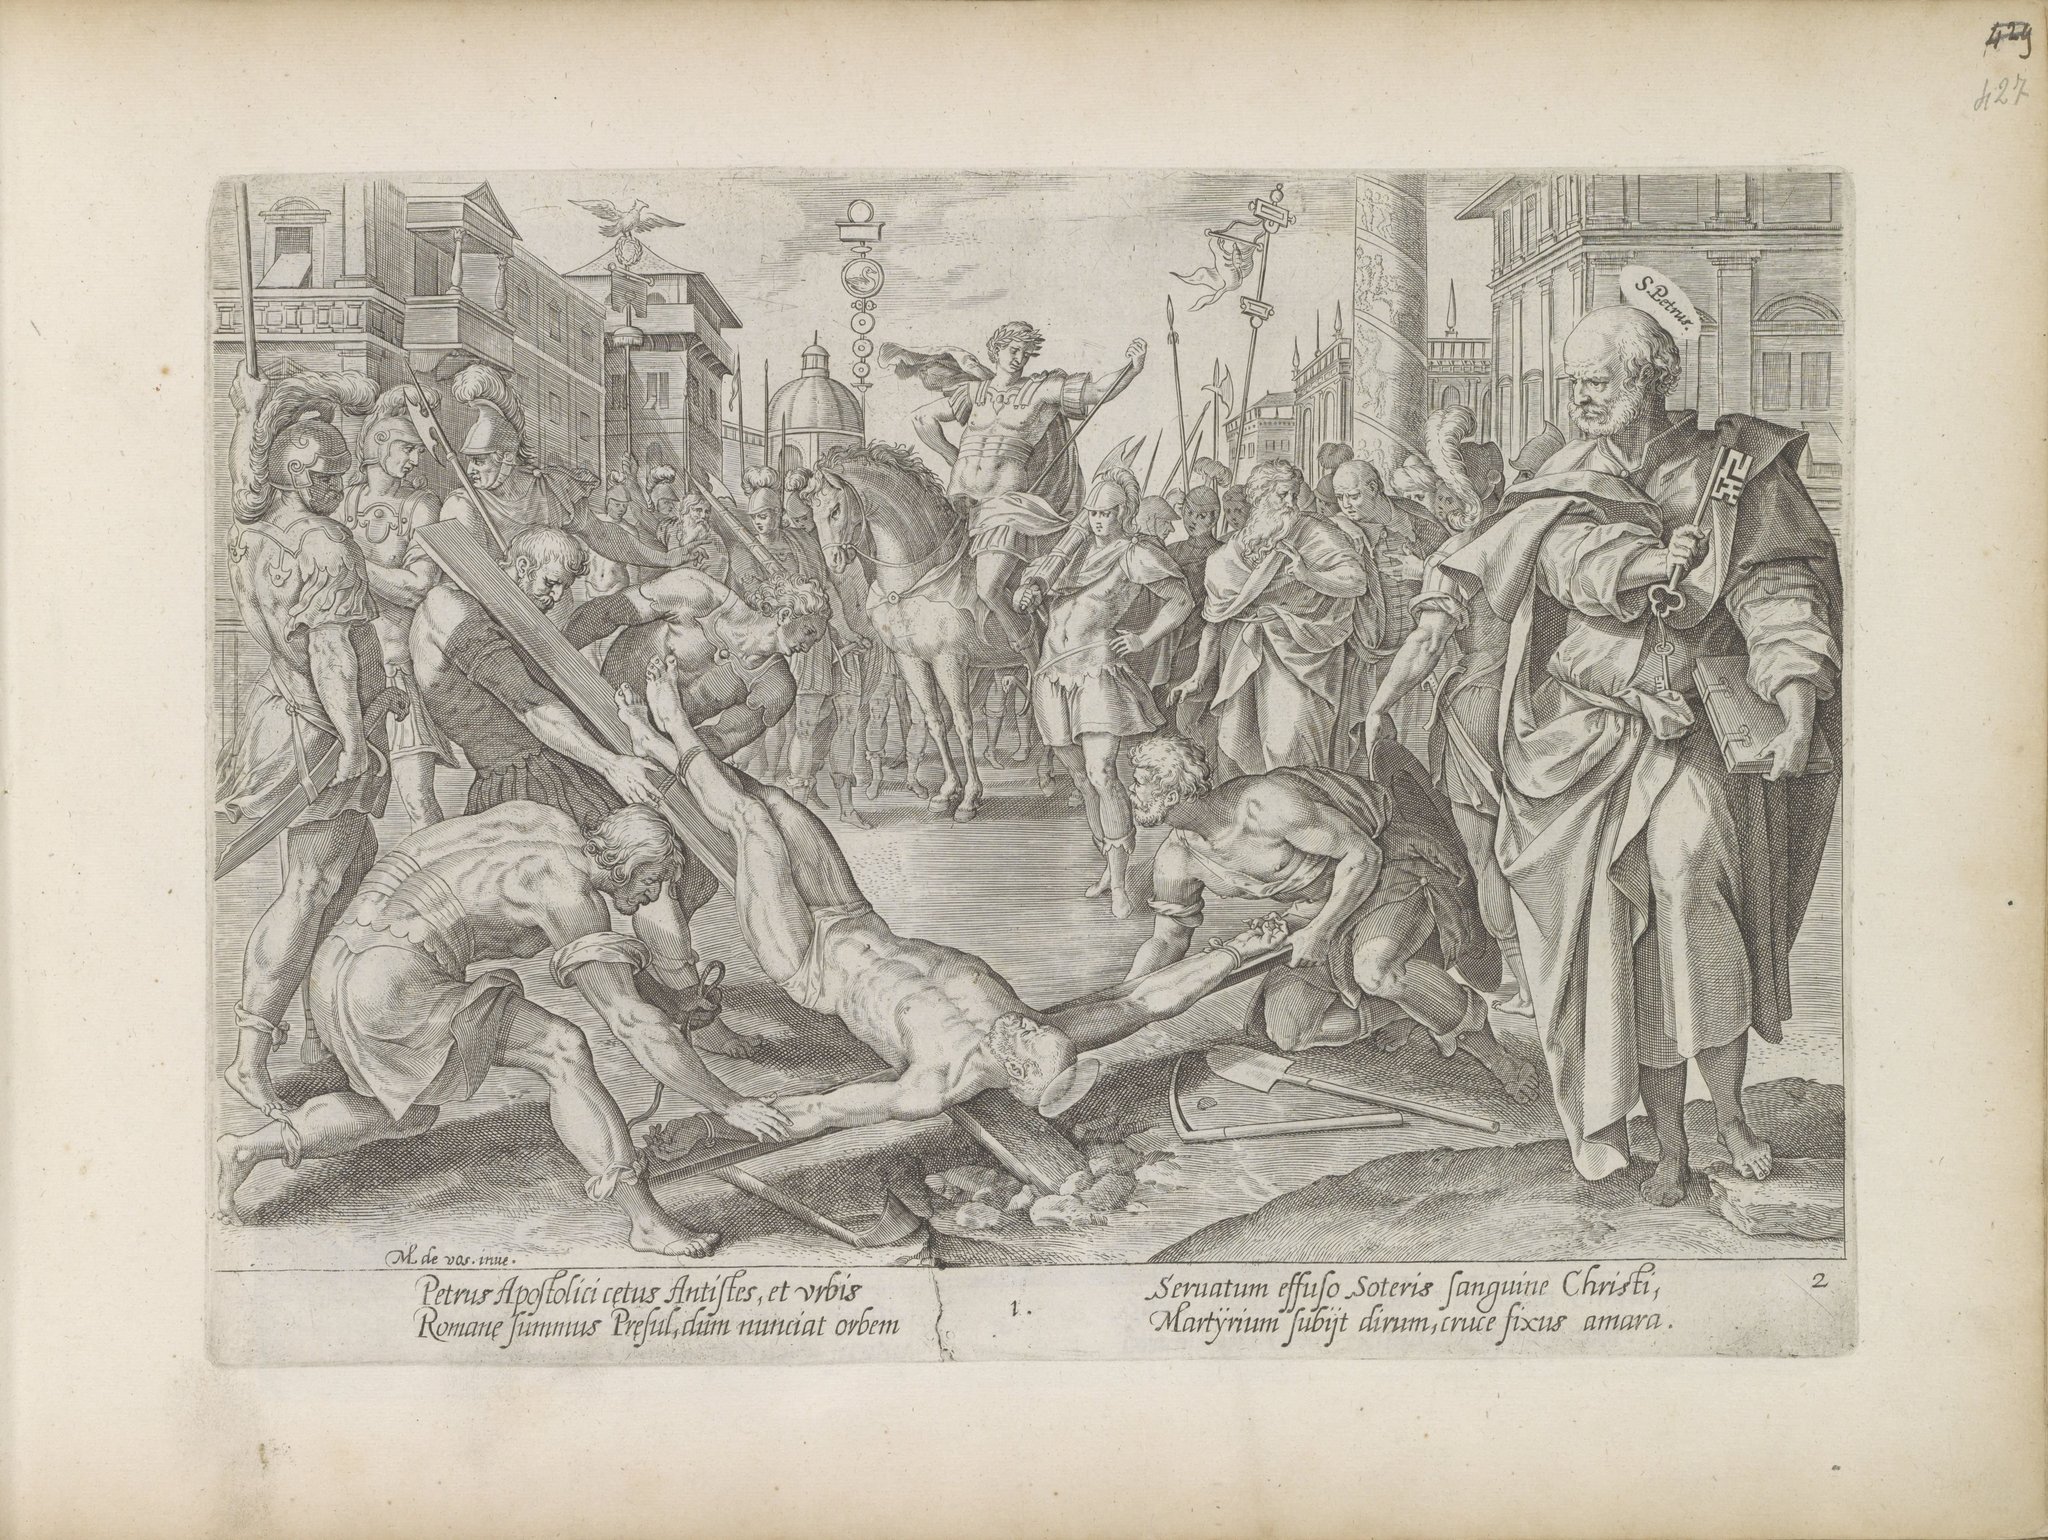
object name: album leaf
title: Martelaarschap van Christus en de apostelen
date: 1576-1580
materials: paper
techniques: engraving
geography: amsterdam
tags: peter crucified upside down, the apostle peter, first bishop of rome; possible attributes: book, cock, (upturned) cross, (triple) crozier, fish, key, scroll, ship, tiara - martyrdom, suffering, misfortune, death of male saint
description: Petrus wordt ondersteboven gekruisigd. Rechts naast het tafereel van zijn marteldood staat hij nogmaals afgebeeld met sleutels in de hand. Onder de voorstelling een verklarende tekst in het Latijn. Deze prent maakt deel uit van een album.